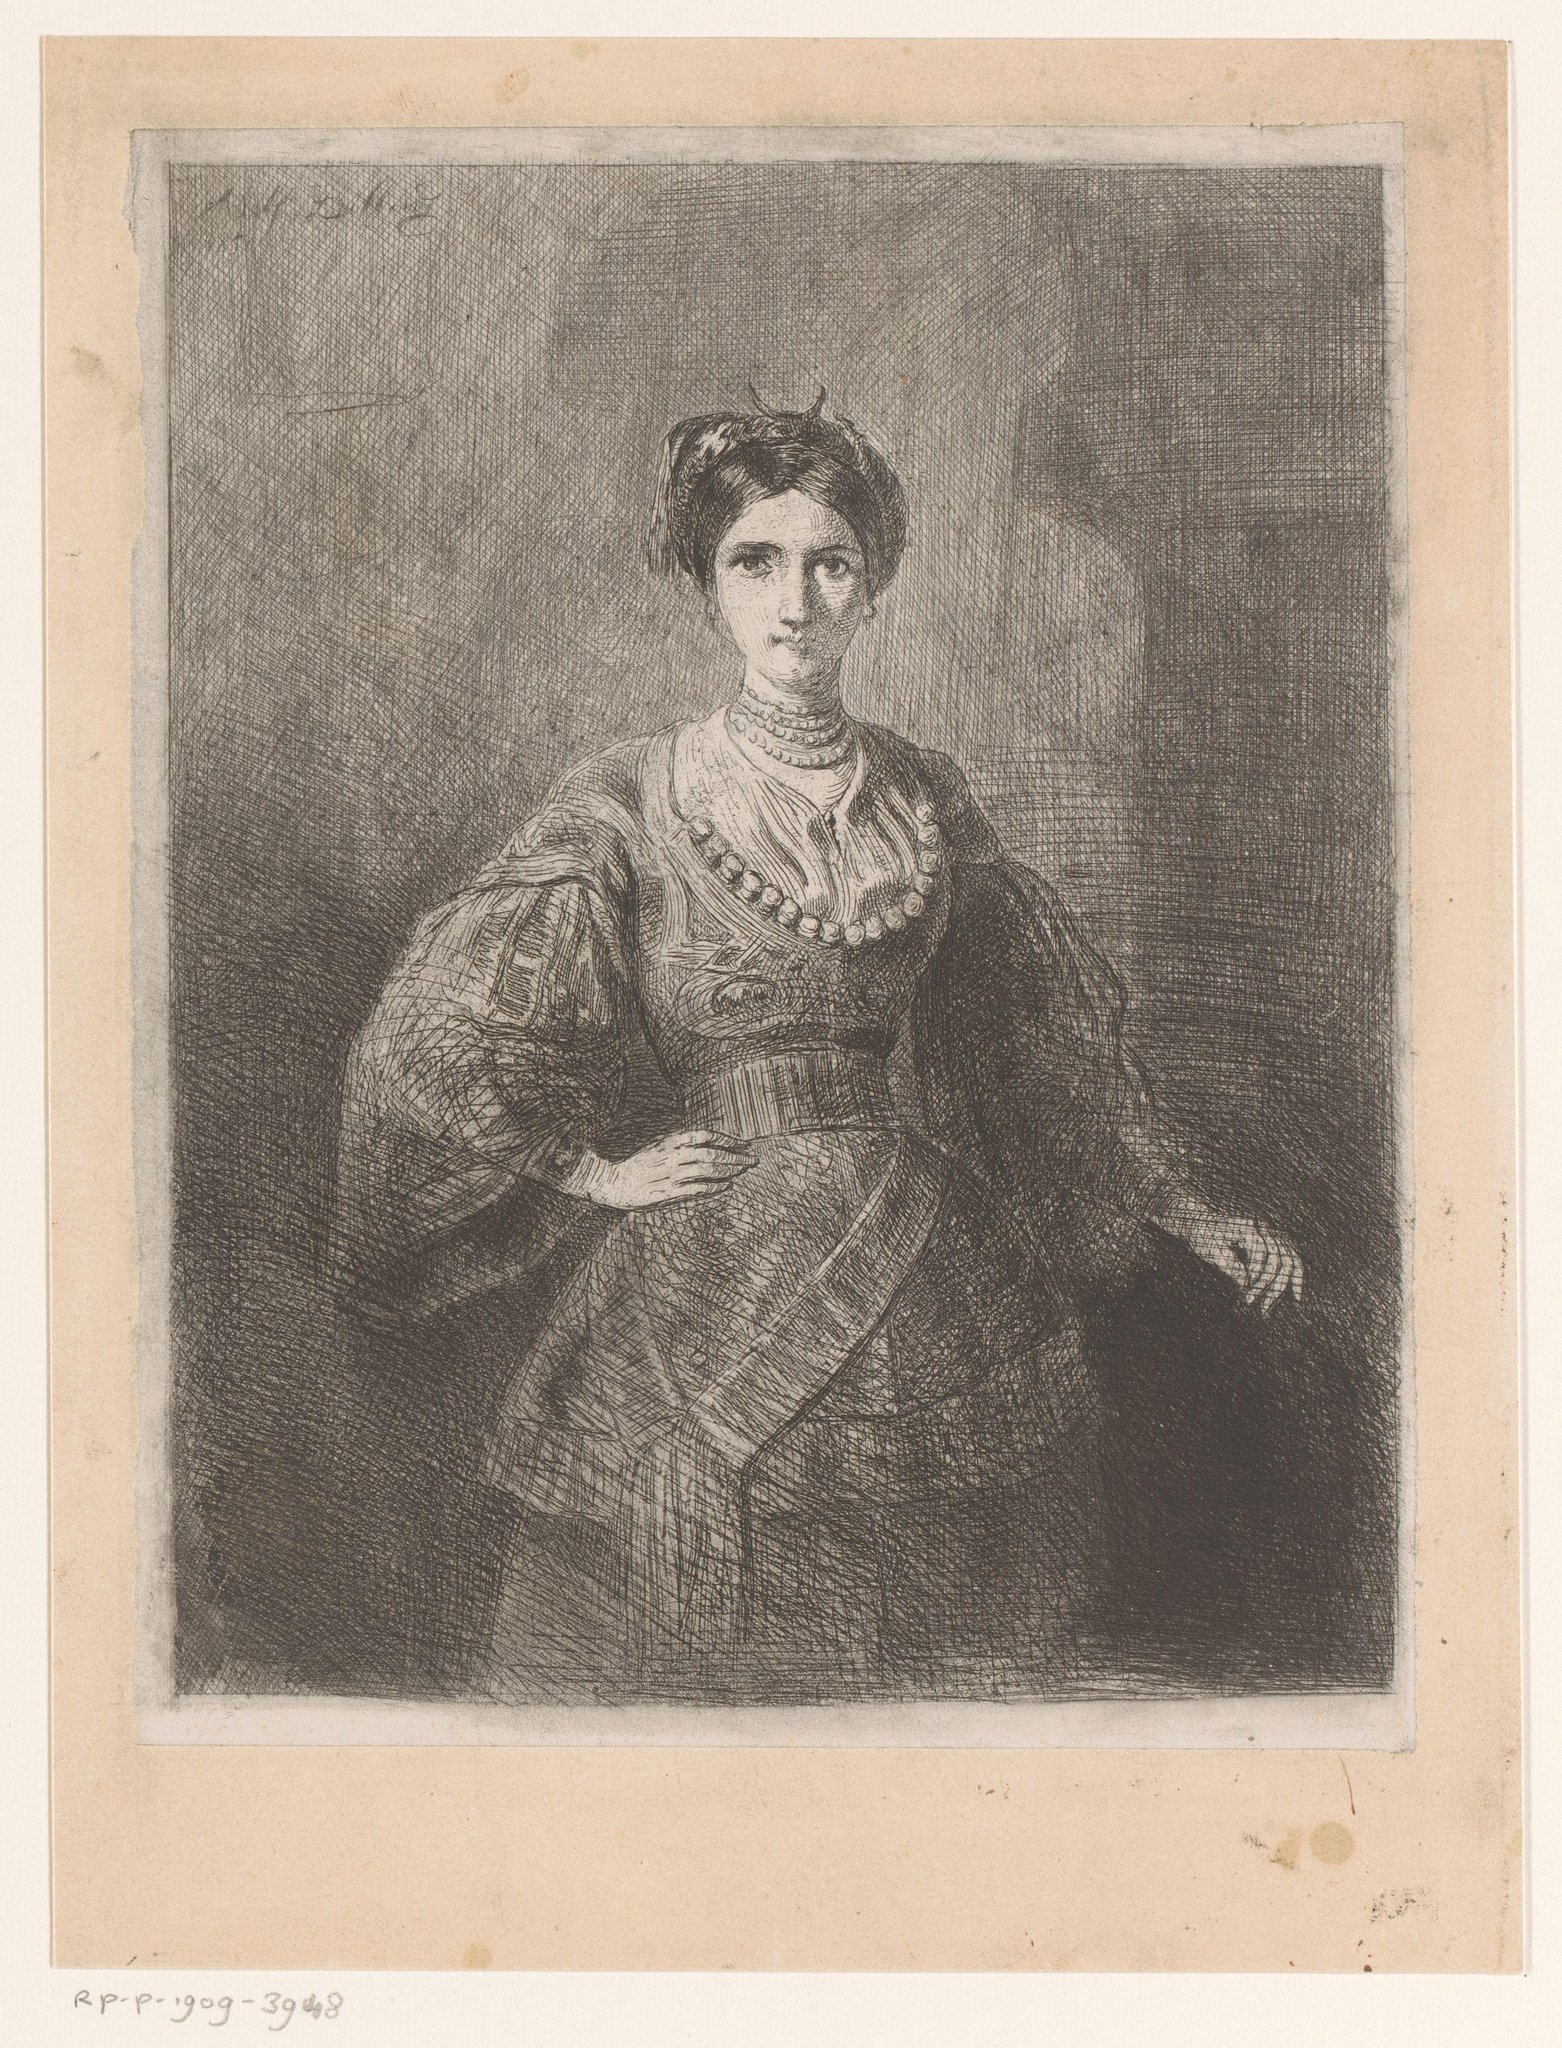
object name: print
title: Portret van een onbekende jonge vrouw in Turkse klederdracht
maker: adolphe alexandre dillens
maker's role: draughtsman, painter, print maker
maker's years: 1821-1877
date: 1831-1877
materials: paper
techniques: etching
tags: adolescent, young woman, maiden, historical persons, standing figure - aa - female human figure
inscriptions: collector's mark: Lugt 2228